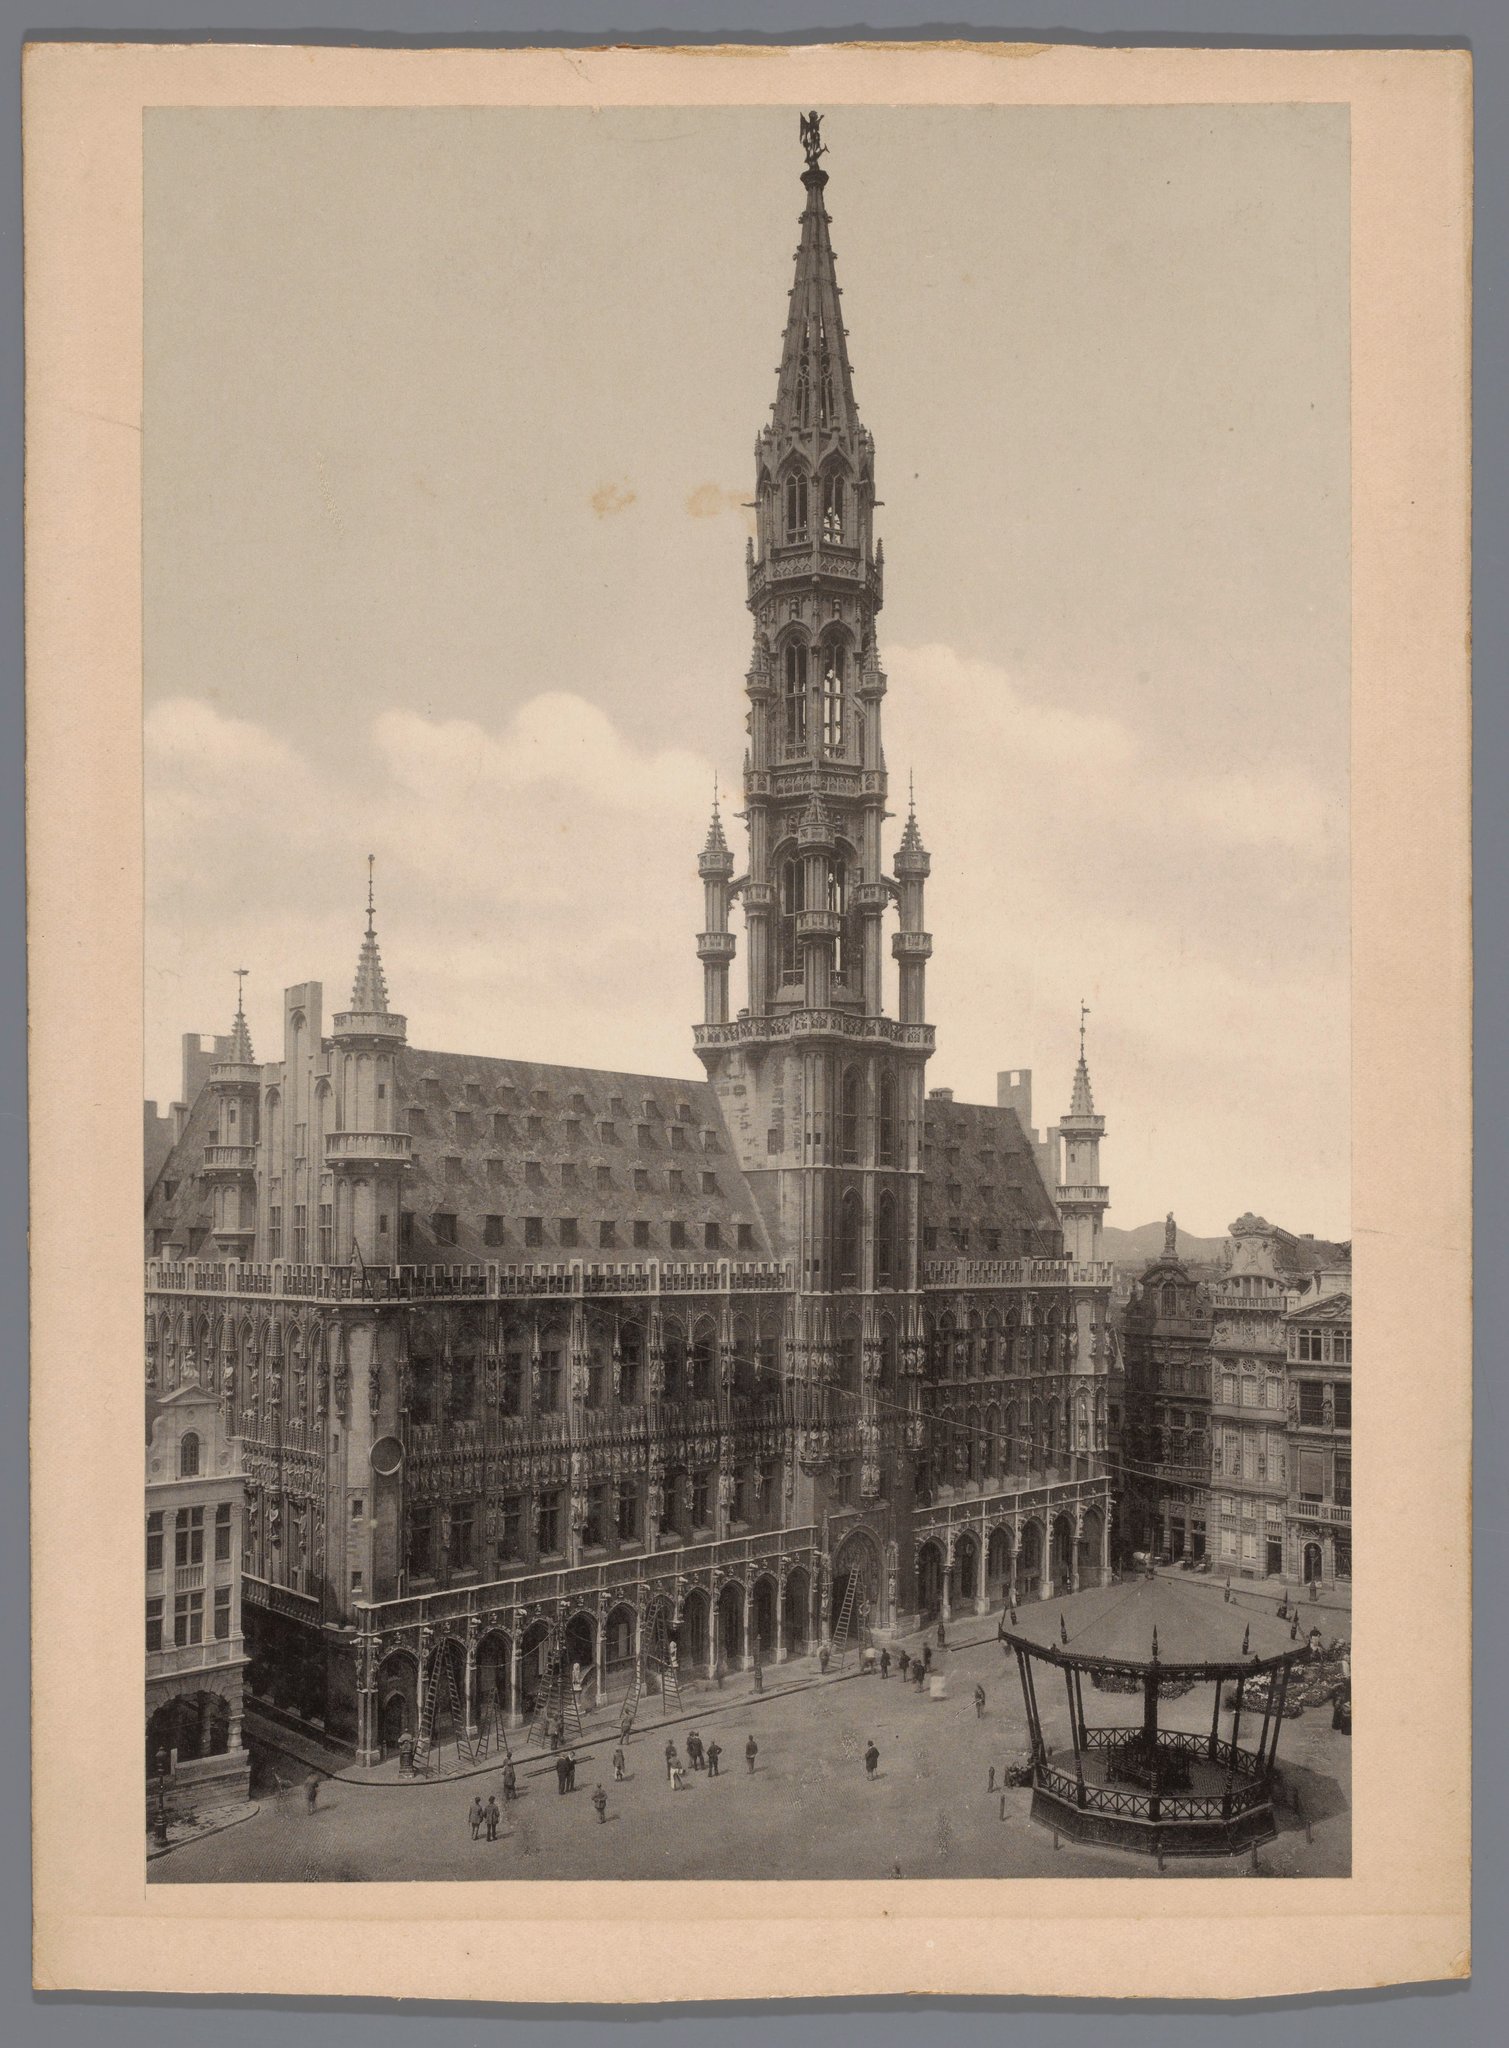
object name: photomechanical print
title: Stadhuis aan de Grote Markt te Brussel, België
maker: Anonymous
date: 1875-1900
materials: cardboard, paper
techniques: photograph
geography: brussels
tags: square, place, circus, etc., townhall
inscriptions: inscription: ‘Brussel’